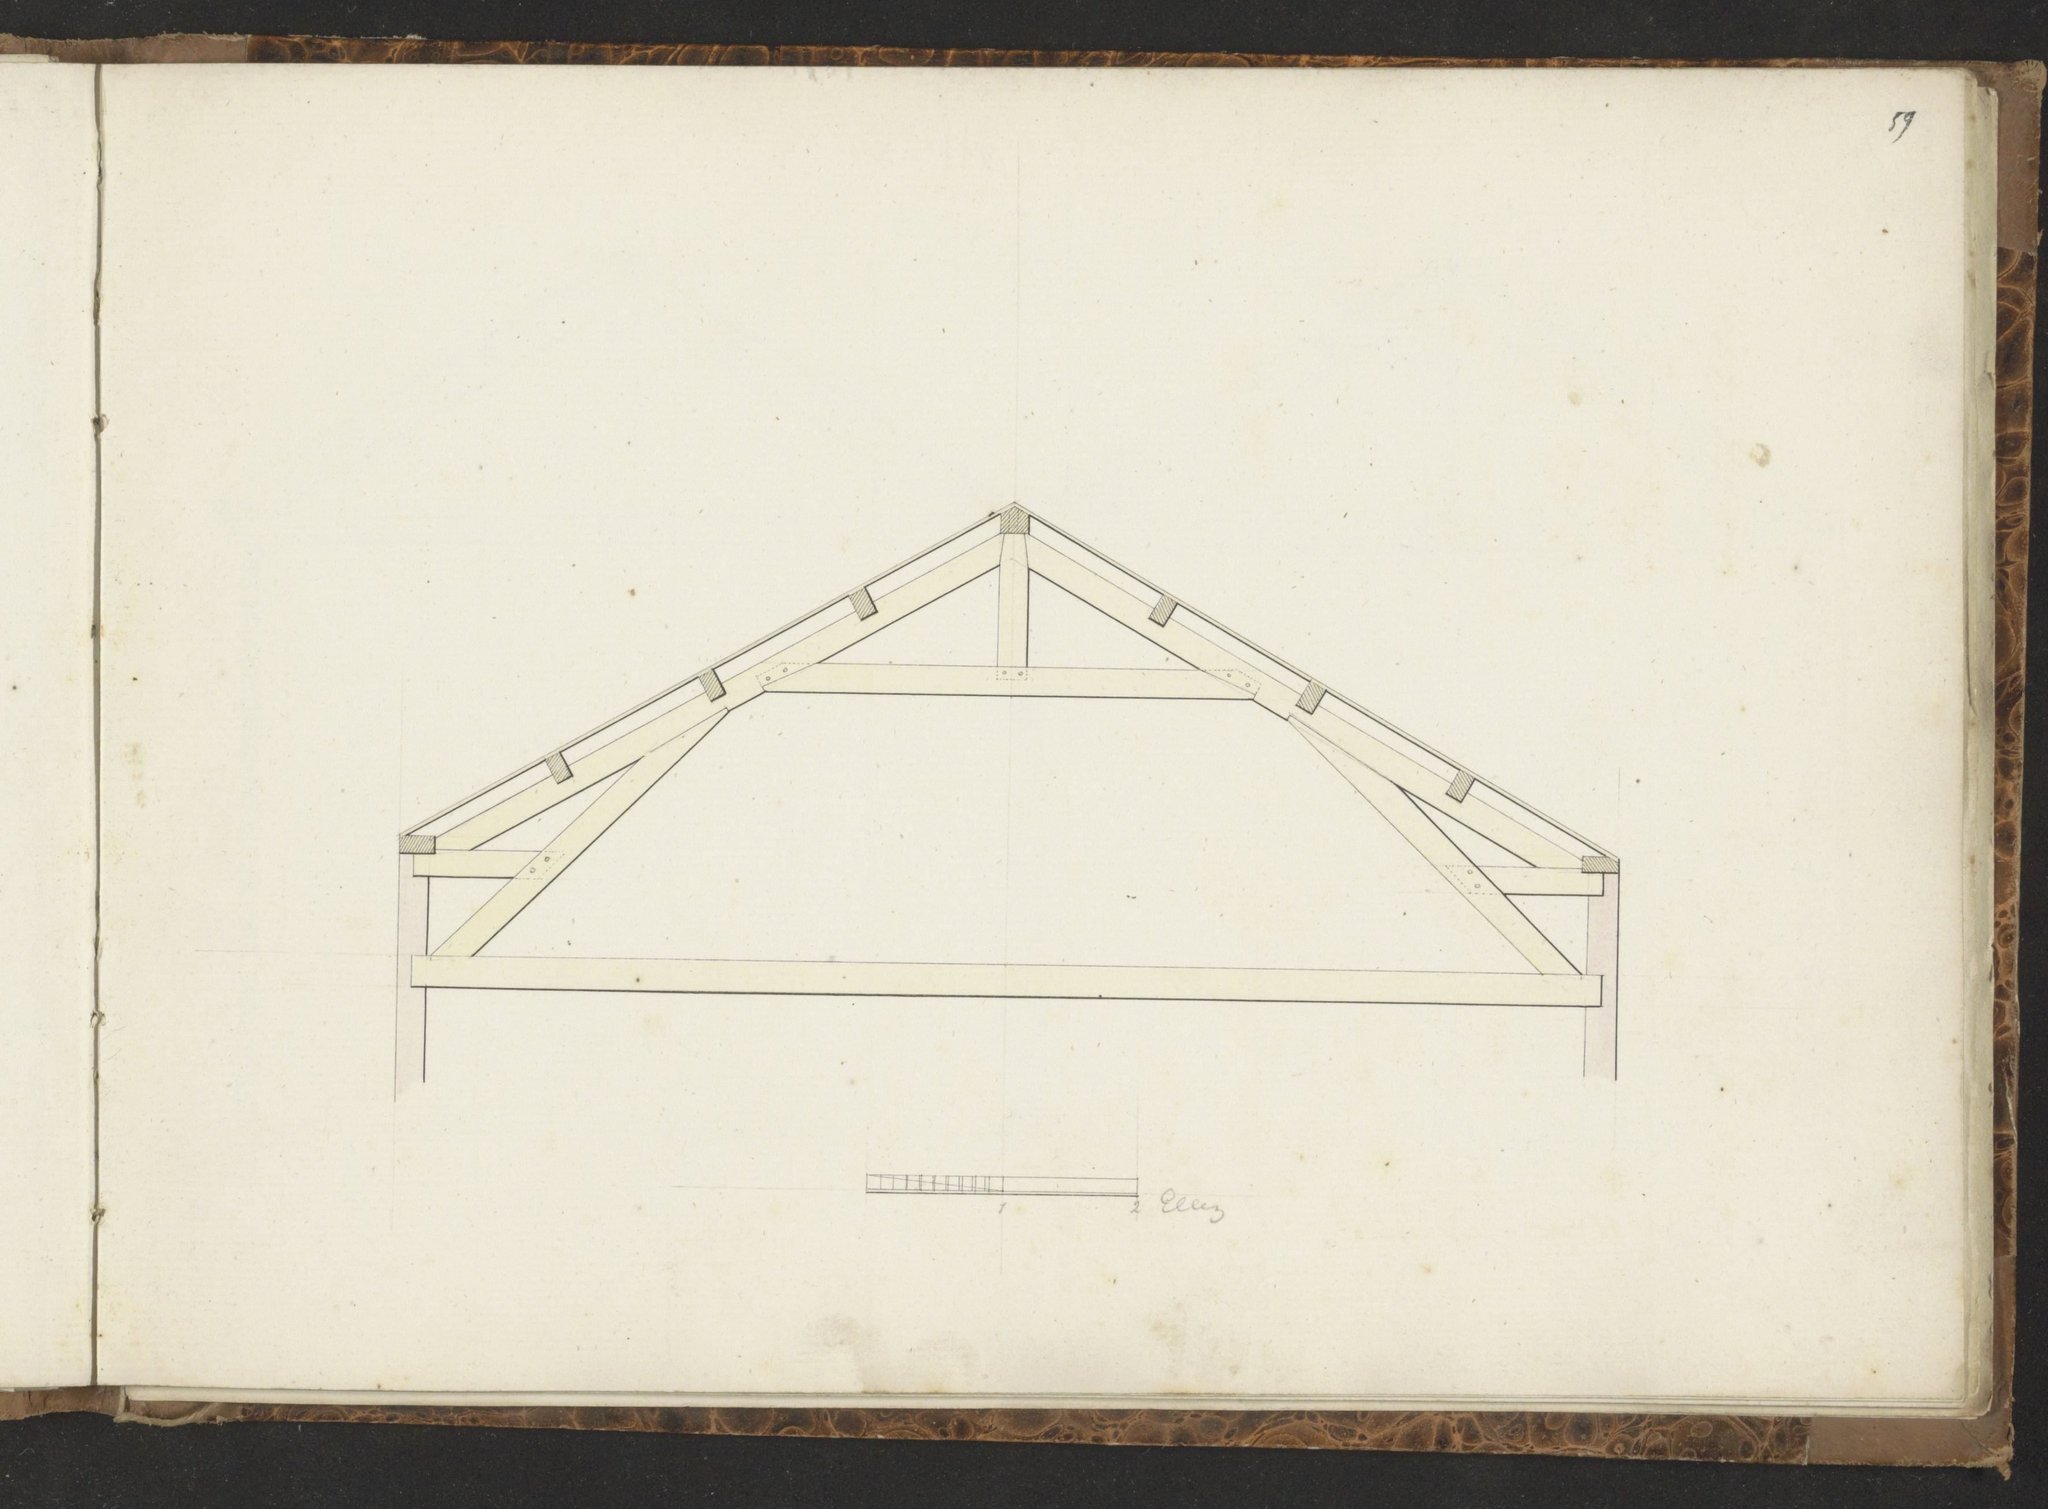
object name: sketchbook leaf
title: Dakconstructie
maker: willem springer jr.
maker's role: draughtsman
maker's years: 1815-1907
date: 1825-1907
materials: ink, paper, pencil, watercolor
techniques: brush, pen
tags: roof (of house or building)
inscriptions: annotation: ‘[...]’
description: Pagina 59 uit een schetsboek met 86 pagina's.